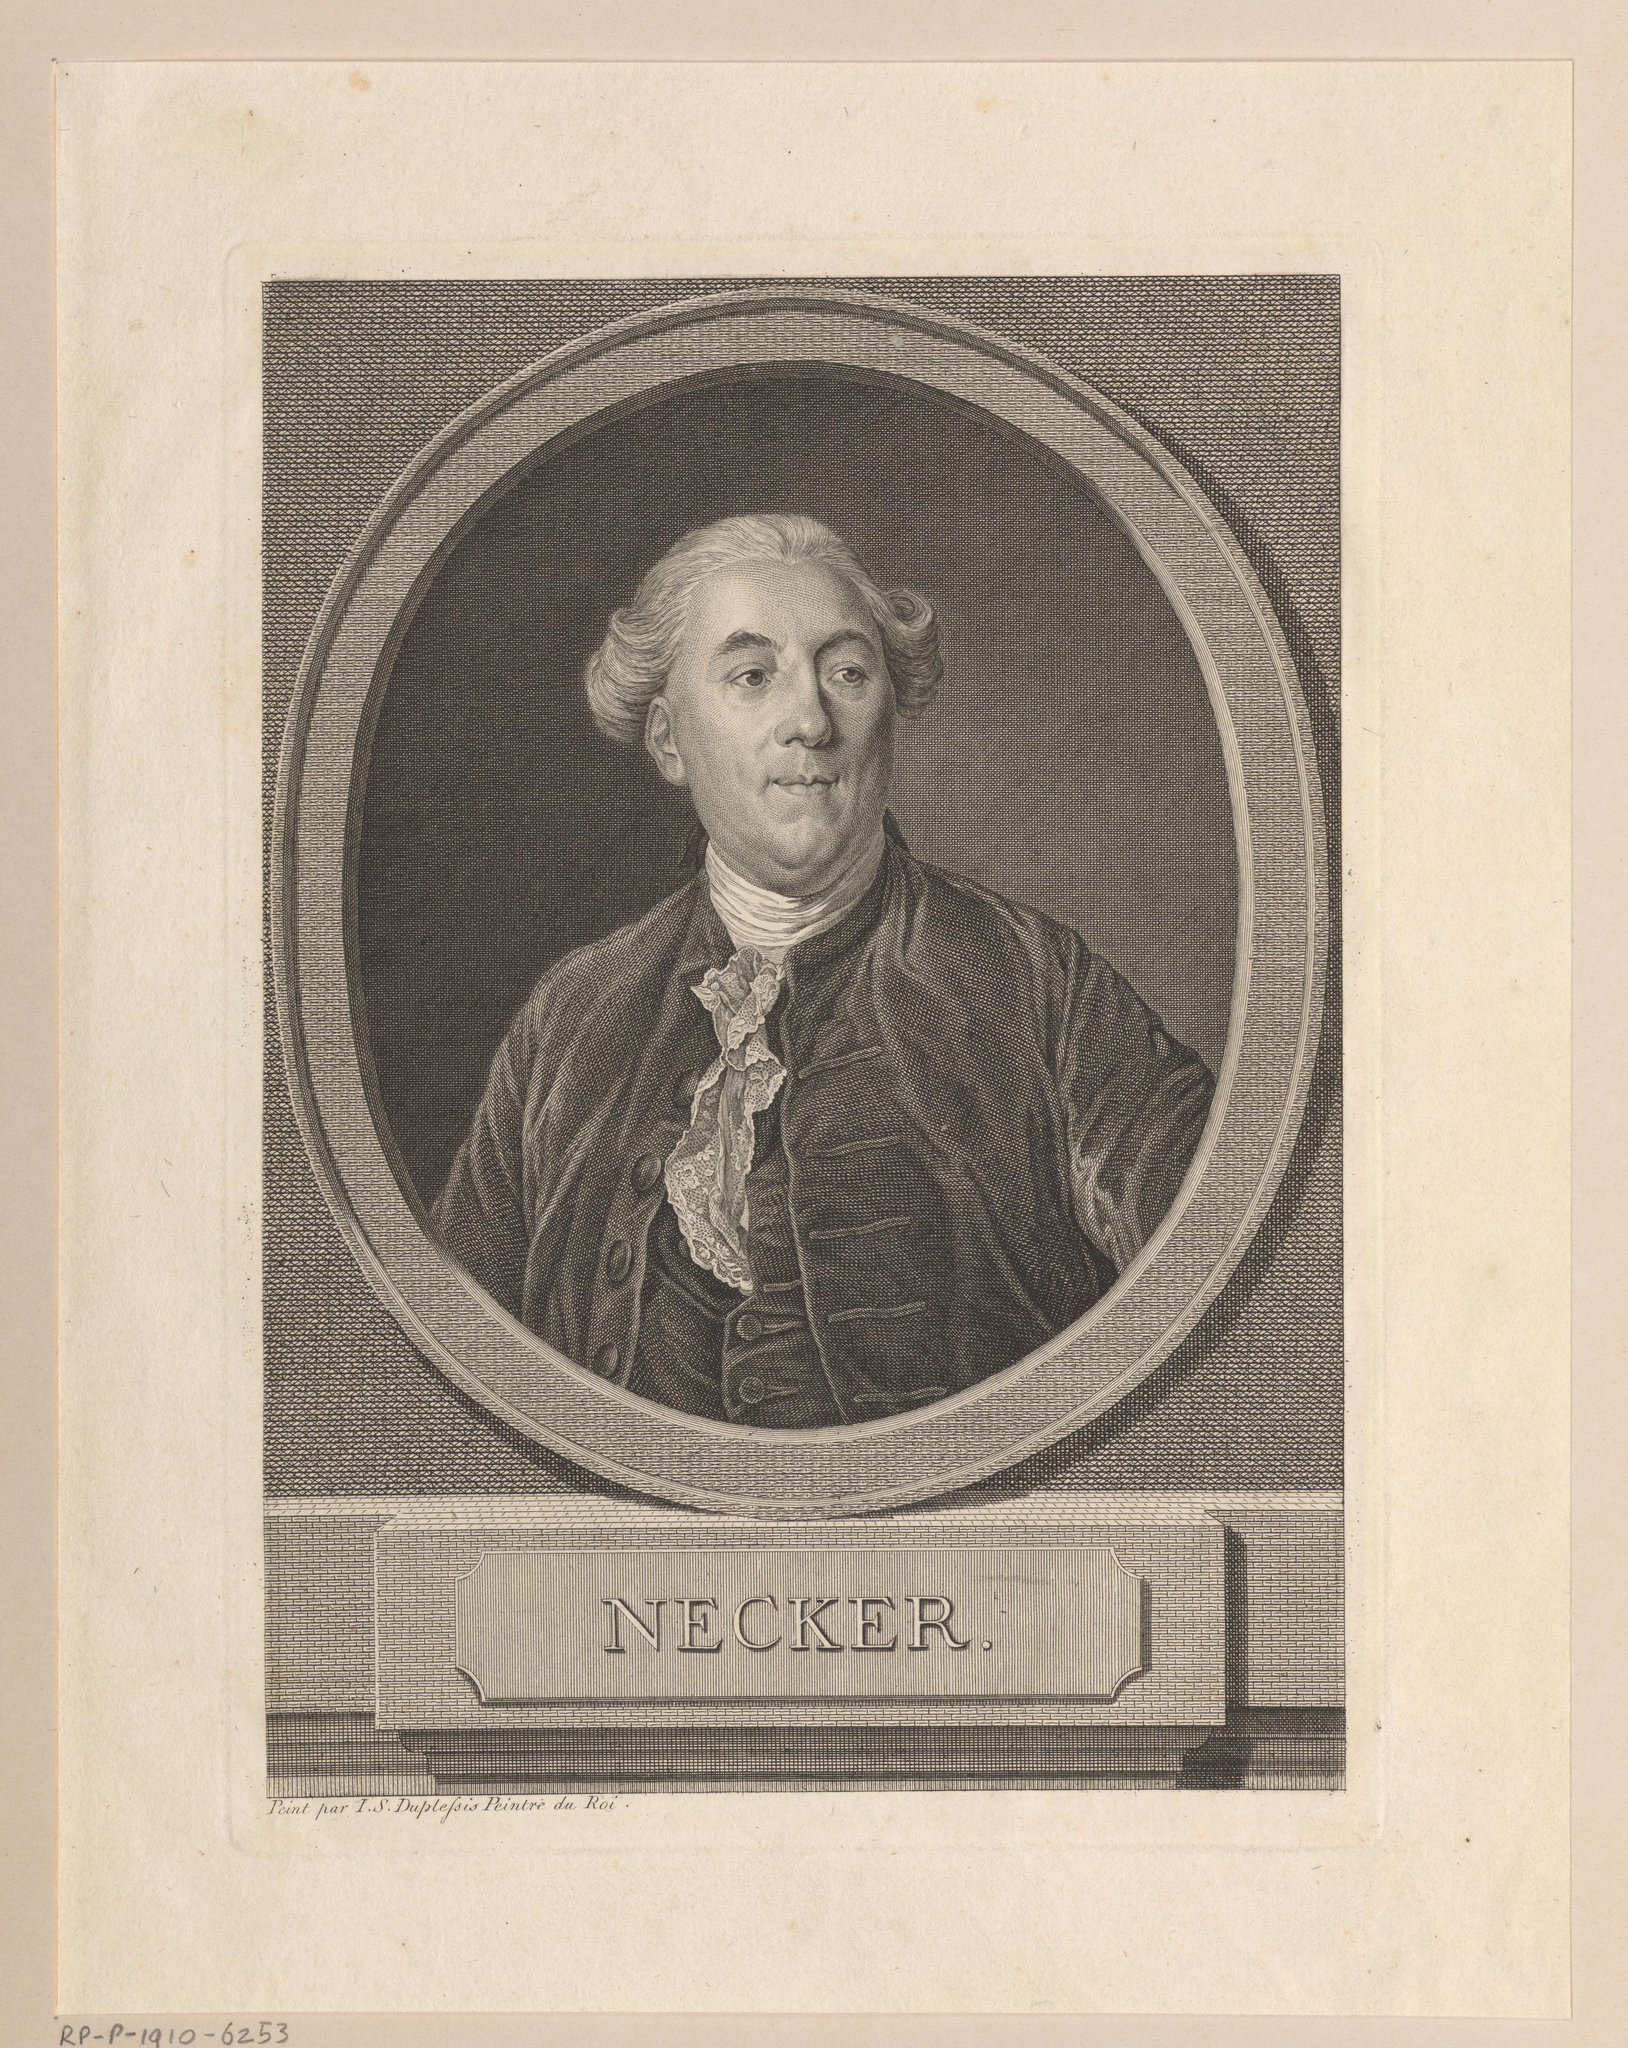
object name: print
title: Portret van Jacques Necker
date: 1785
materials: paper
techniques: engraving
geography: basel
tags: official; civil servant; functionary (in general), historical persons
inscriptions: collector's mark: Lugt 2228